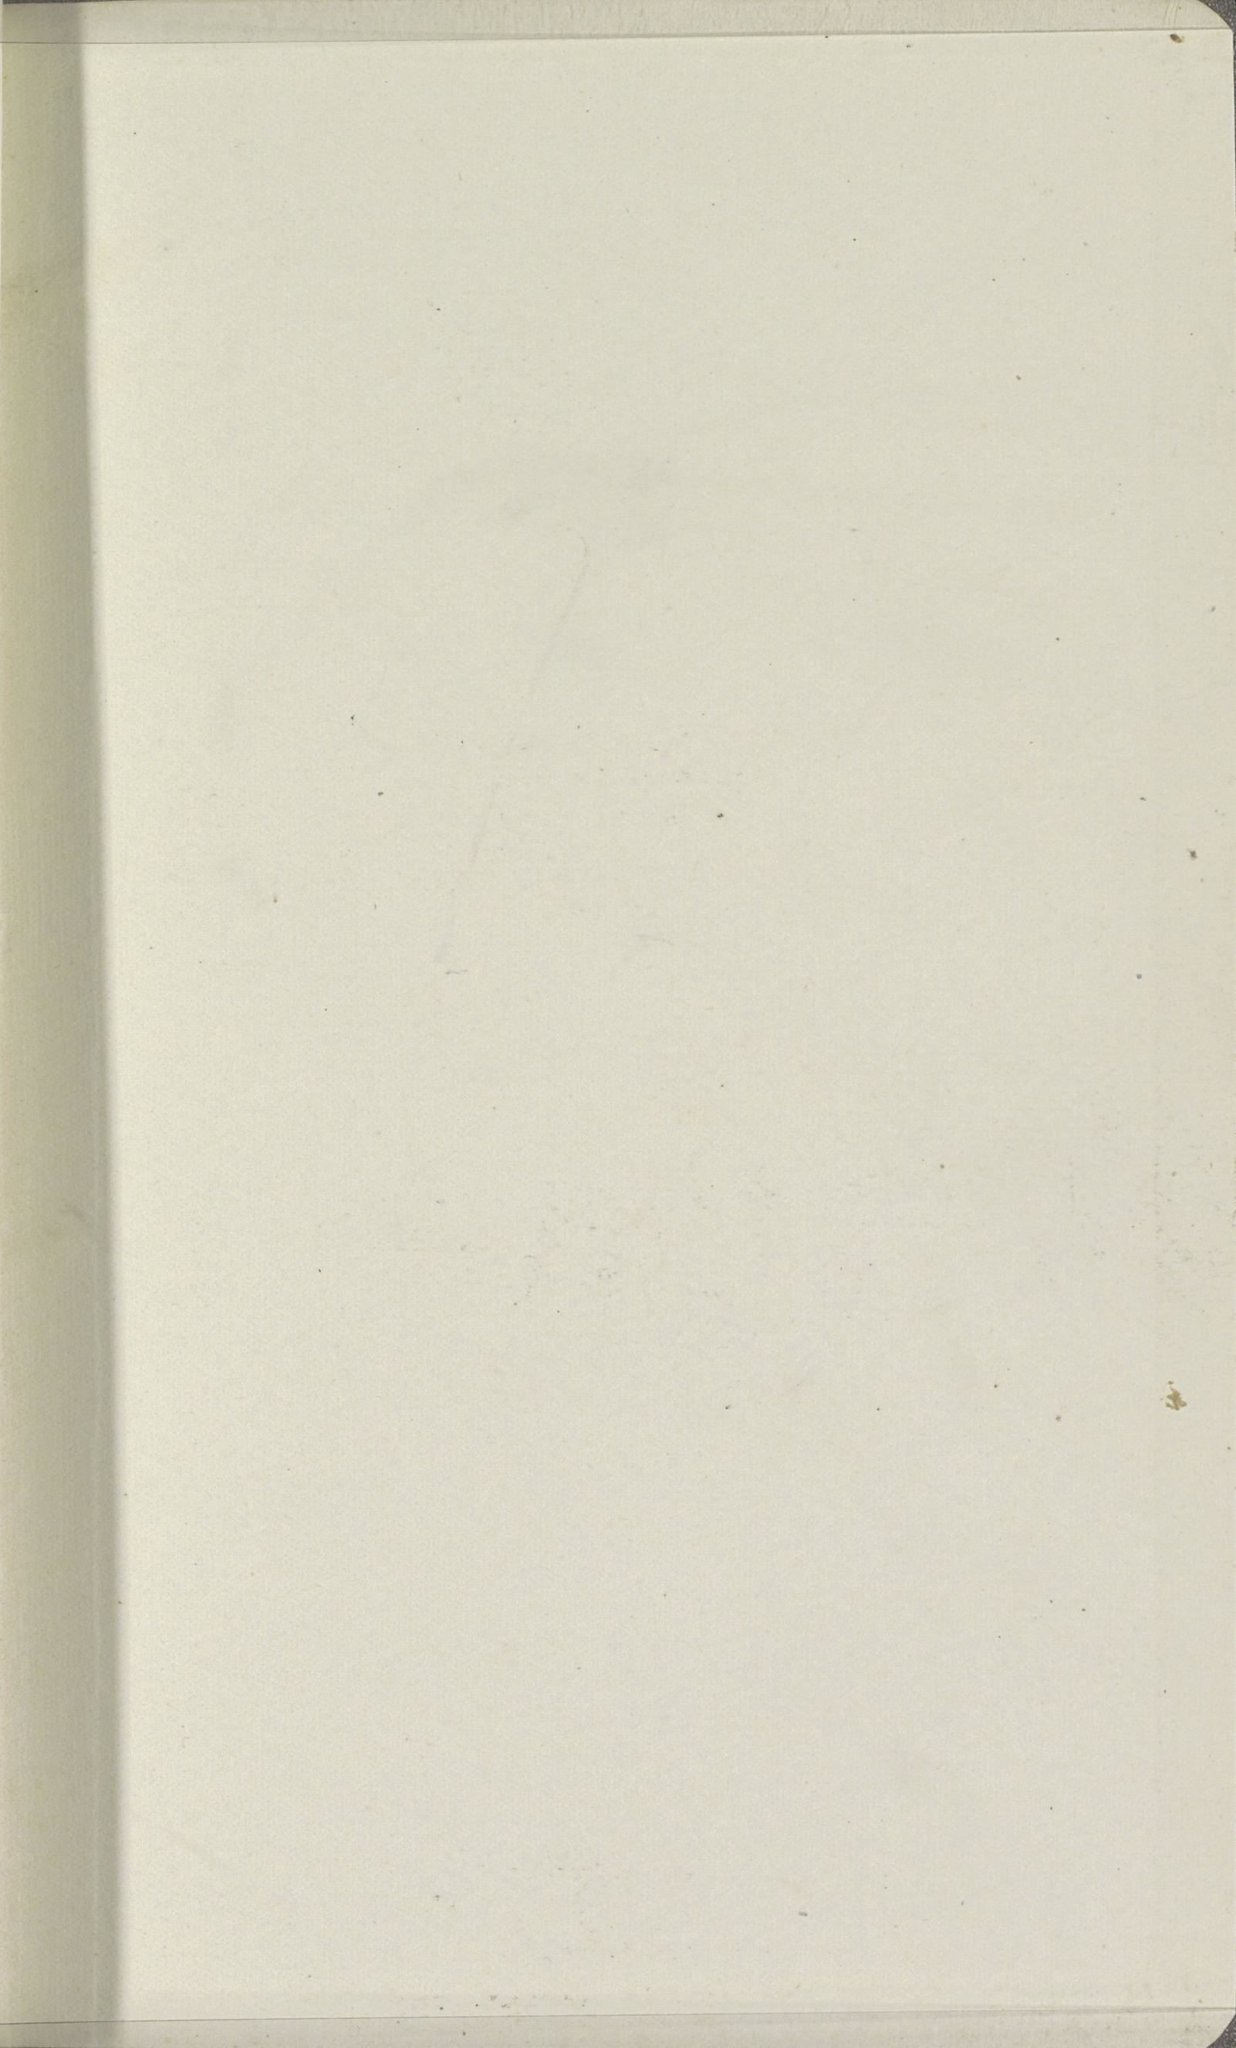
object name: sketchbook leaf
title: Annotaties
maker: willem witsen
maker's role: draughtsman, painter, print maker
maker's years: 1860-1923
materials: paper, pencil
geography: dutch east indies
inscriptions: annotation: ‘[...]’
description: Blad 66 uit een schetsboek met 75 bladen vervaardigd te Nederlands-Indië.